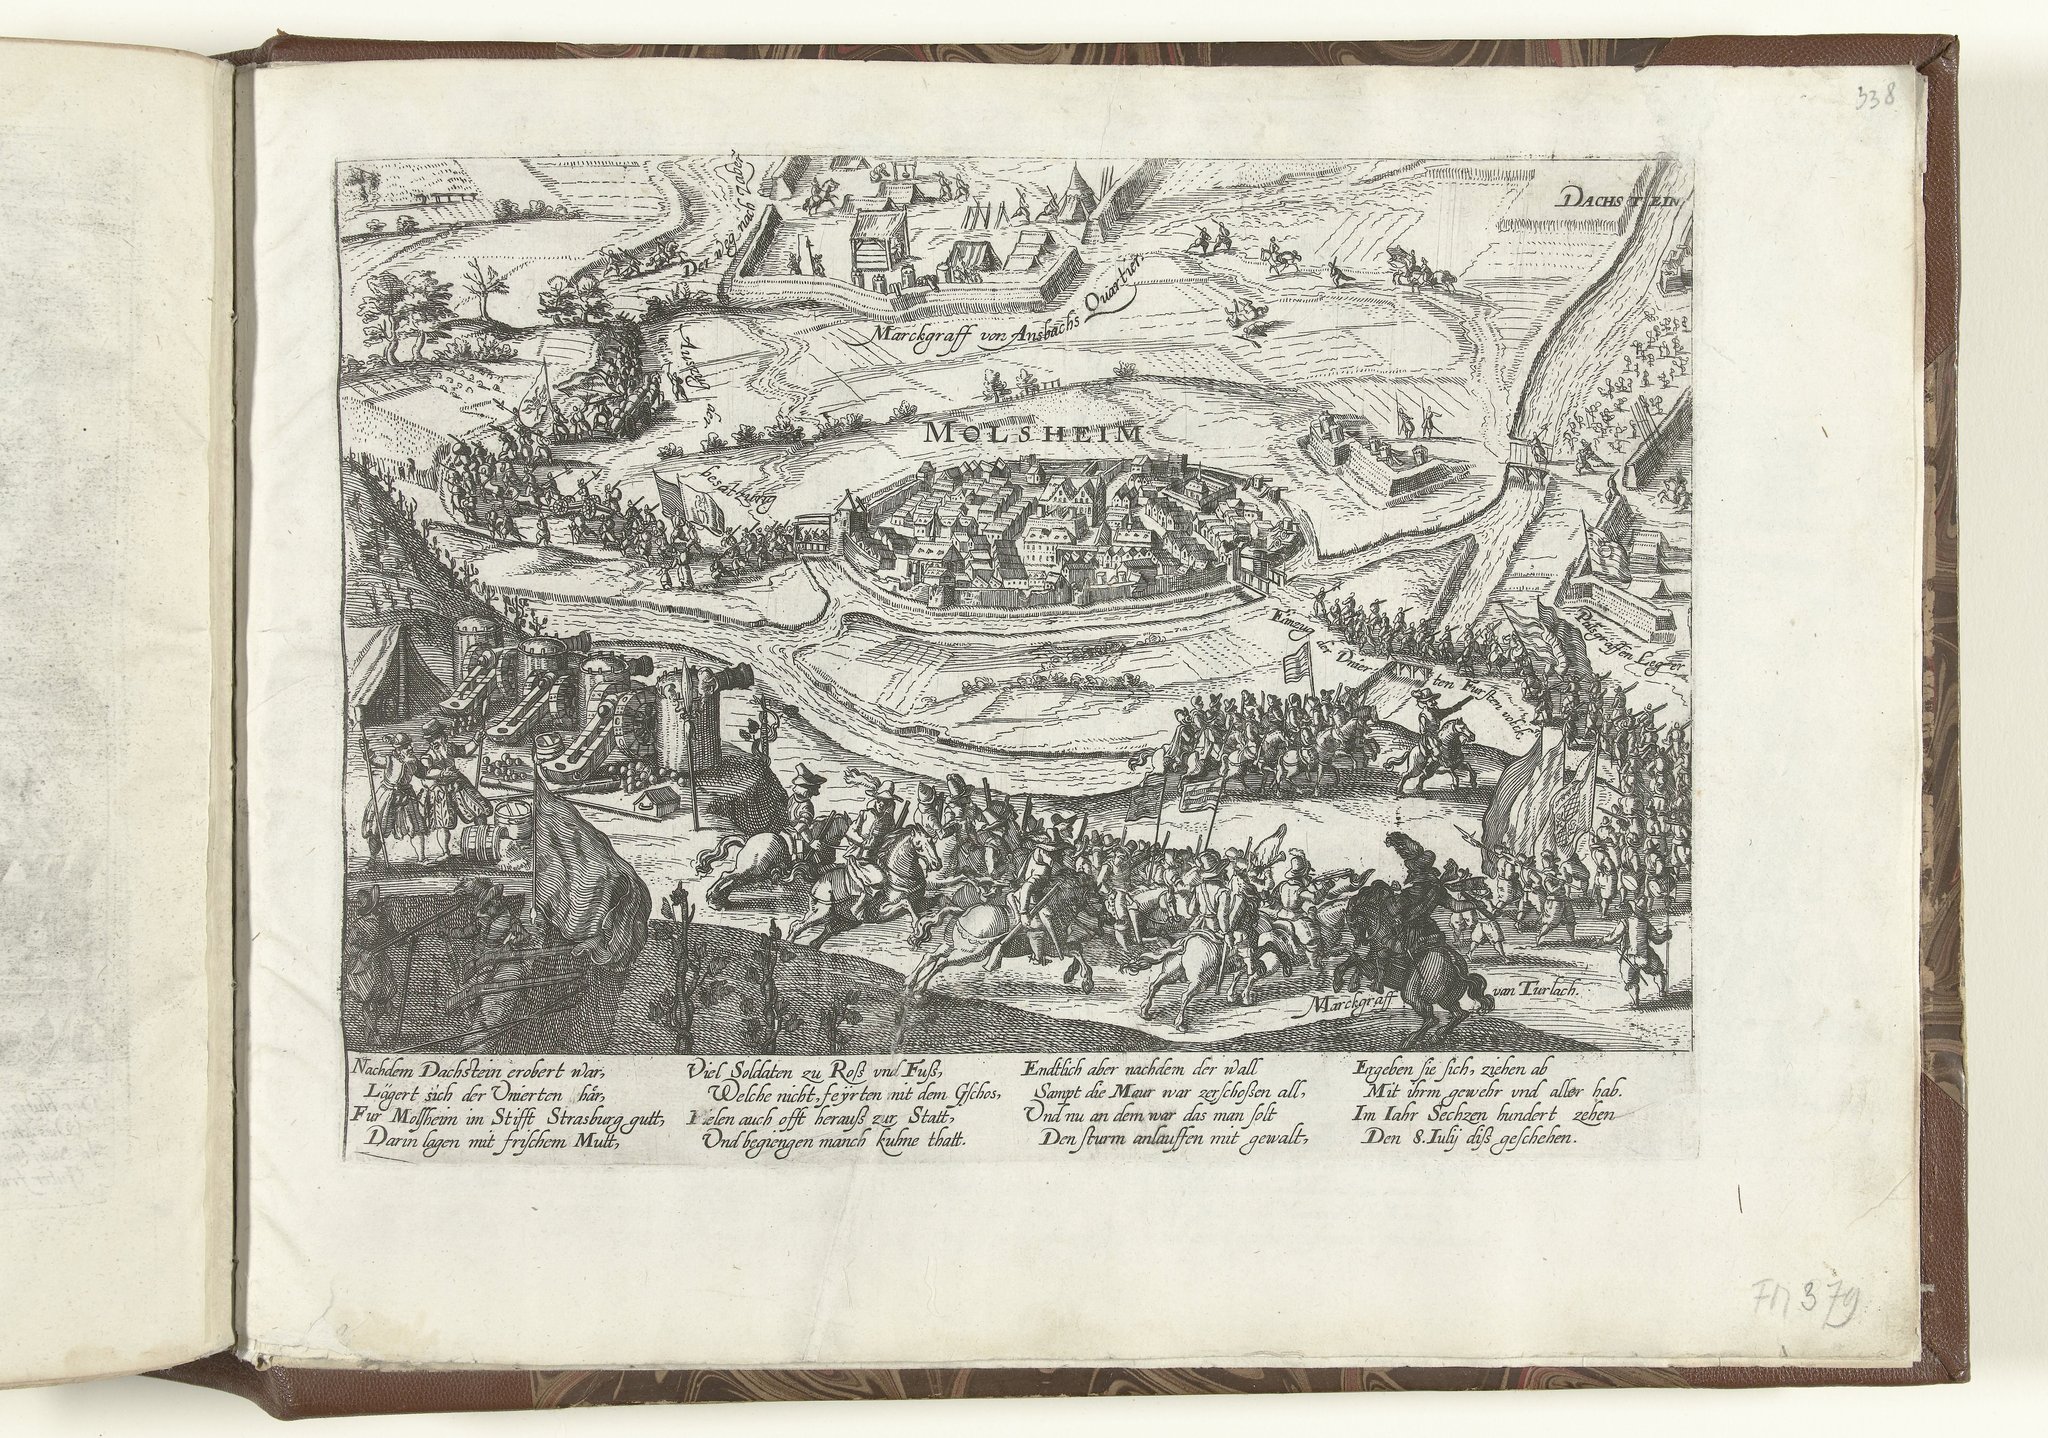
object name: print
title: Verovering van Molsheim in de Elzas, 1610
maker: frans hogenberg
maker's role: print maker, publisher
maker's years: 1538-1590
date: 1610-1612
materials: paper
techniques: etching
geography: cologne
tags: capture of city (after the siege)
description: Verovering van Molsheim in de Elzas, 8 juli 1610. Episode uit de Gulik-Kleefse kwestie. Met onderschrift van 16 regels in het Duits. Ongenummerd.